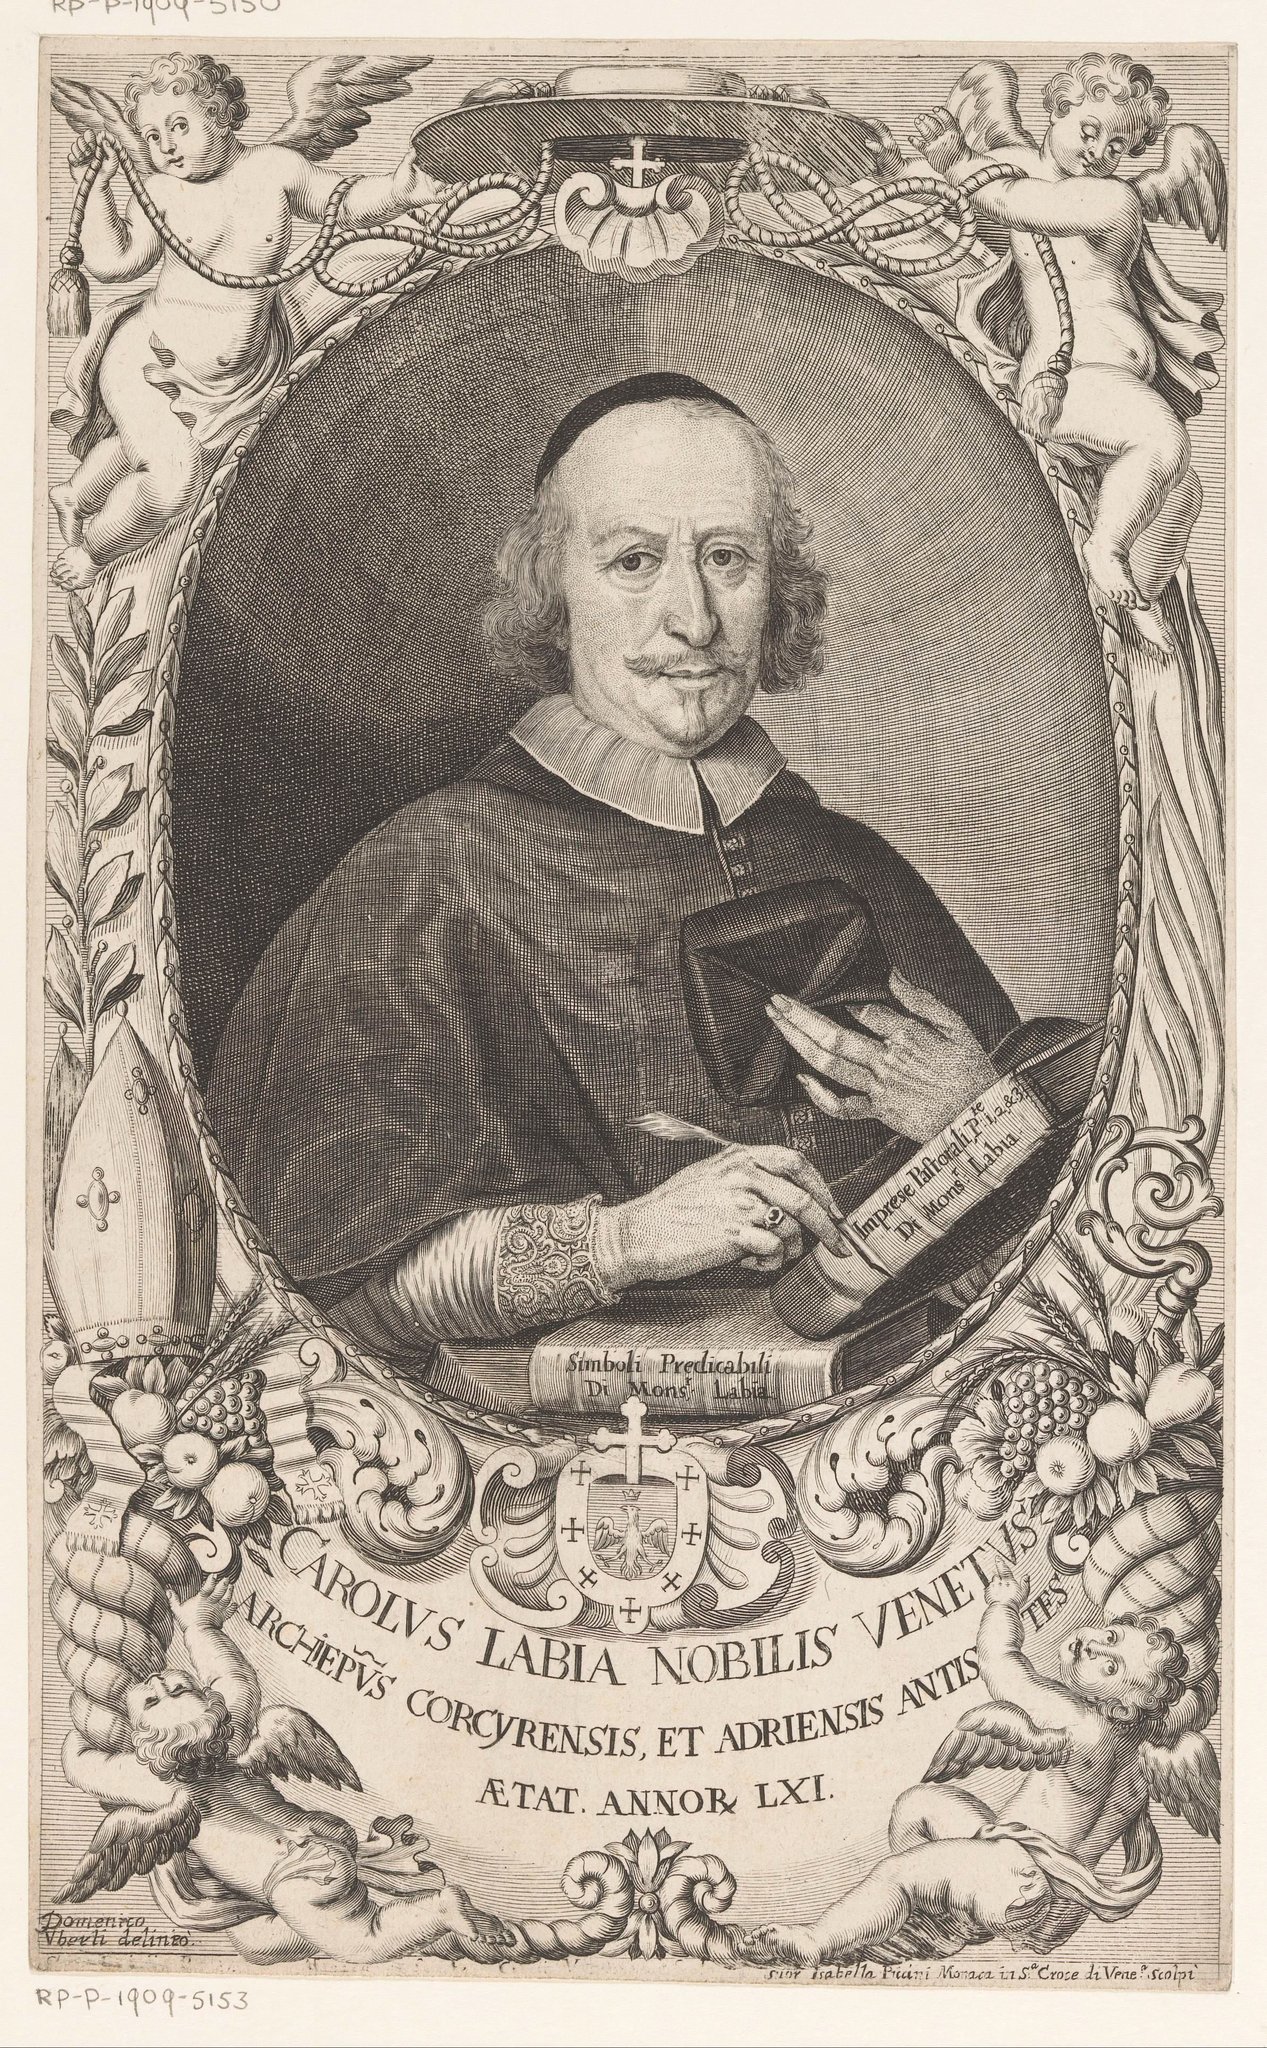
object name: book illustration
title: Portret van aartsbisschop Carlo Labia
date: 1692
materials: paper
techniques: engraving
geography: italy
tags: historical persons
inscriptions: collector's mark: Lugt 2228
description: Prent gebruikt voor de publicatie: Labia, Carlo. Simboli predicabili estratti da sacri Evangeli che corrono nella quadragesima. Ferrara: Barbieri, 1692.